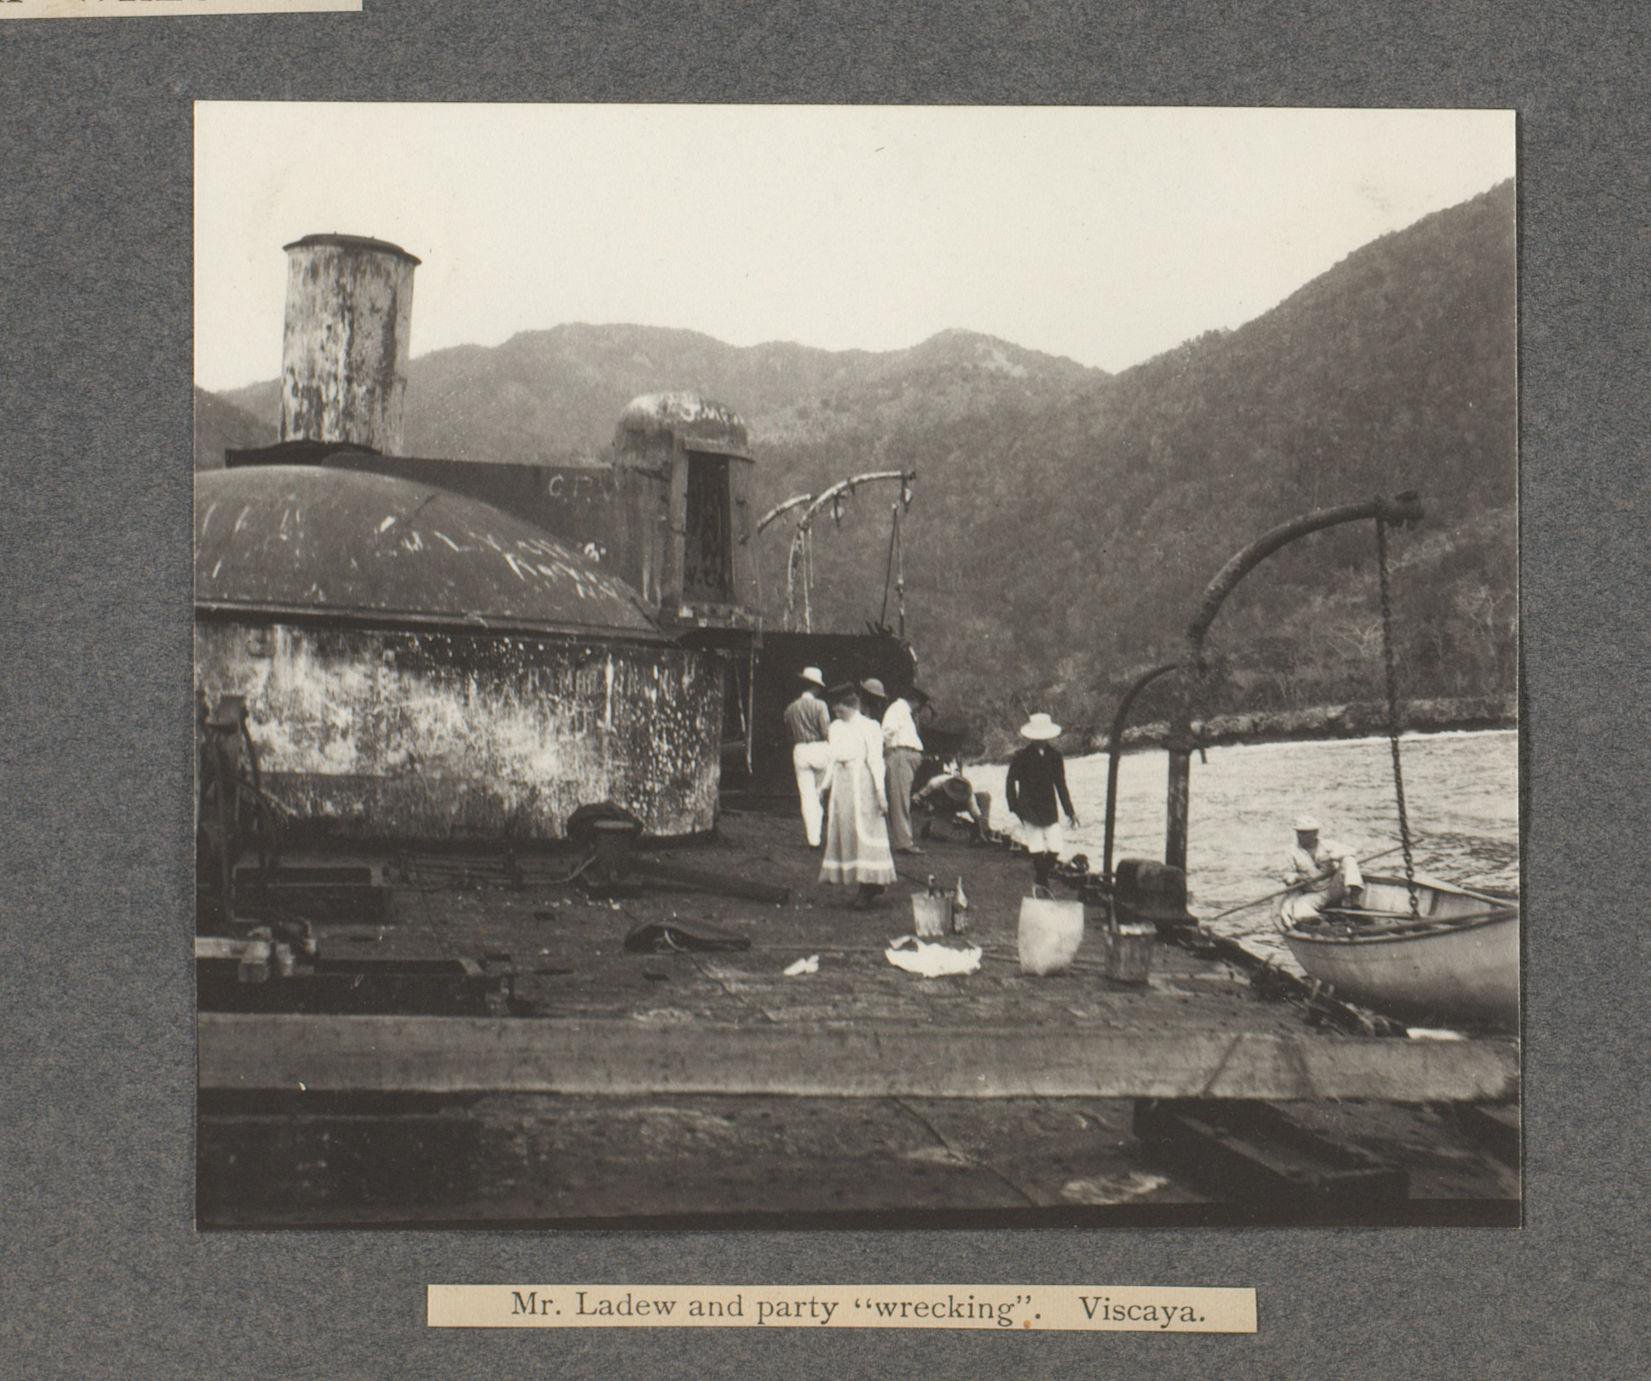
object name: photograph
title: Mr. Ladew and party "wrecking". Viscaya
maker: Anonymous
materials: paper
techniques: platinum process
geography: santiago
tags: joseph harvey ladew sr., gulf, bay, historical persons, shipwreck